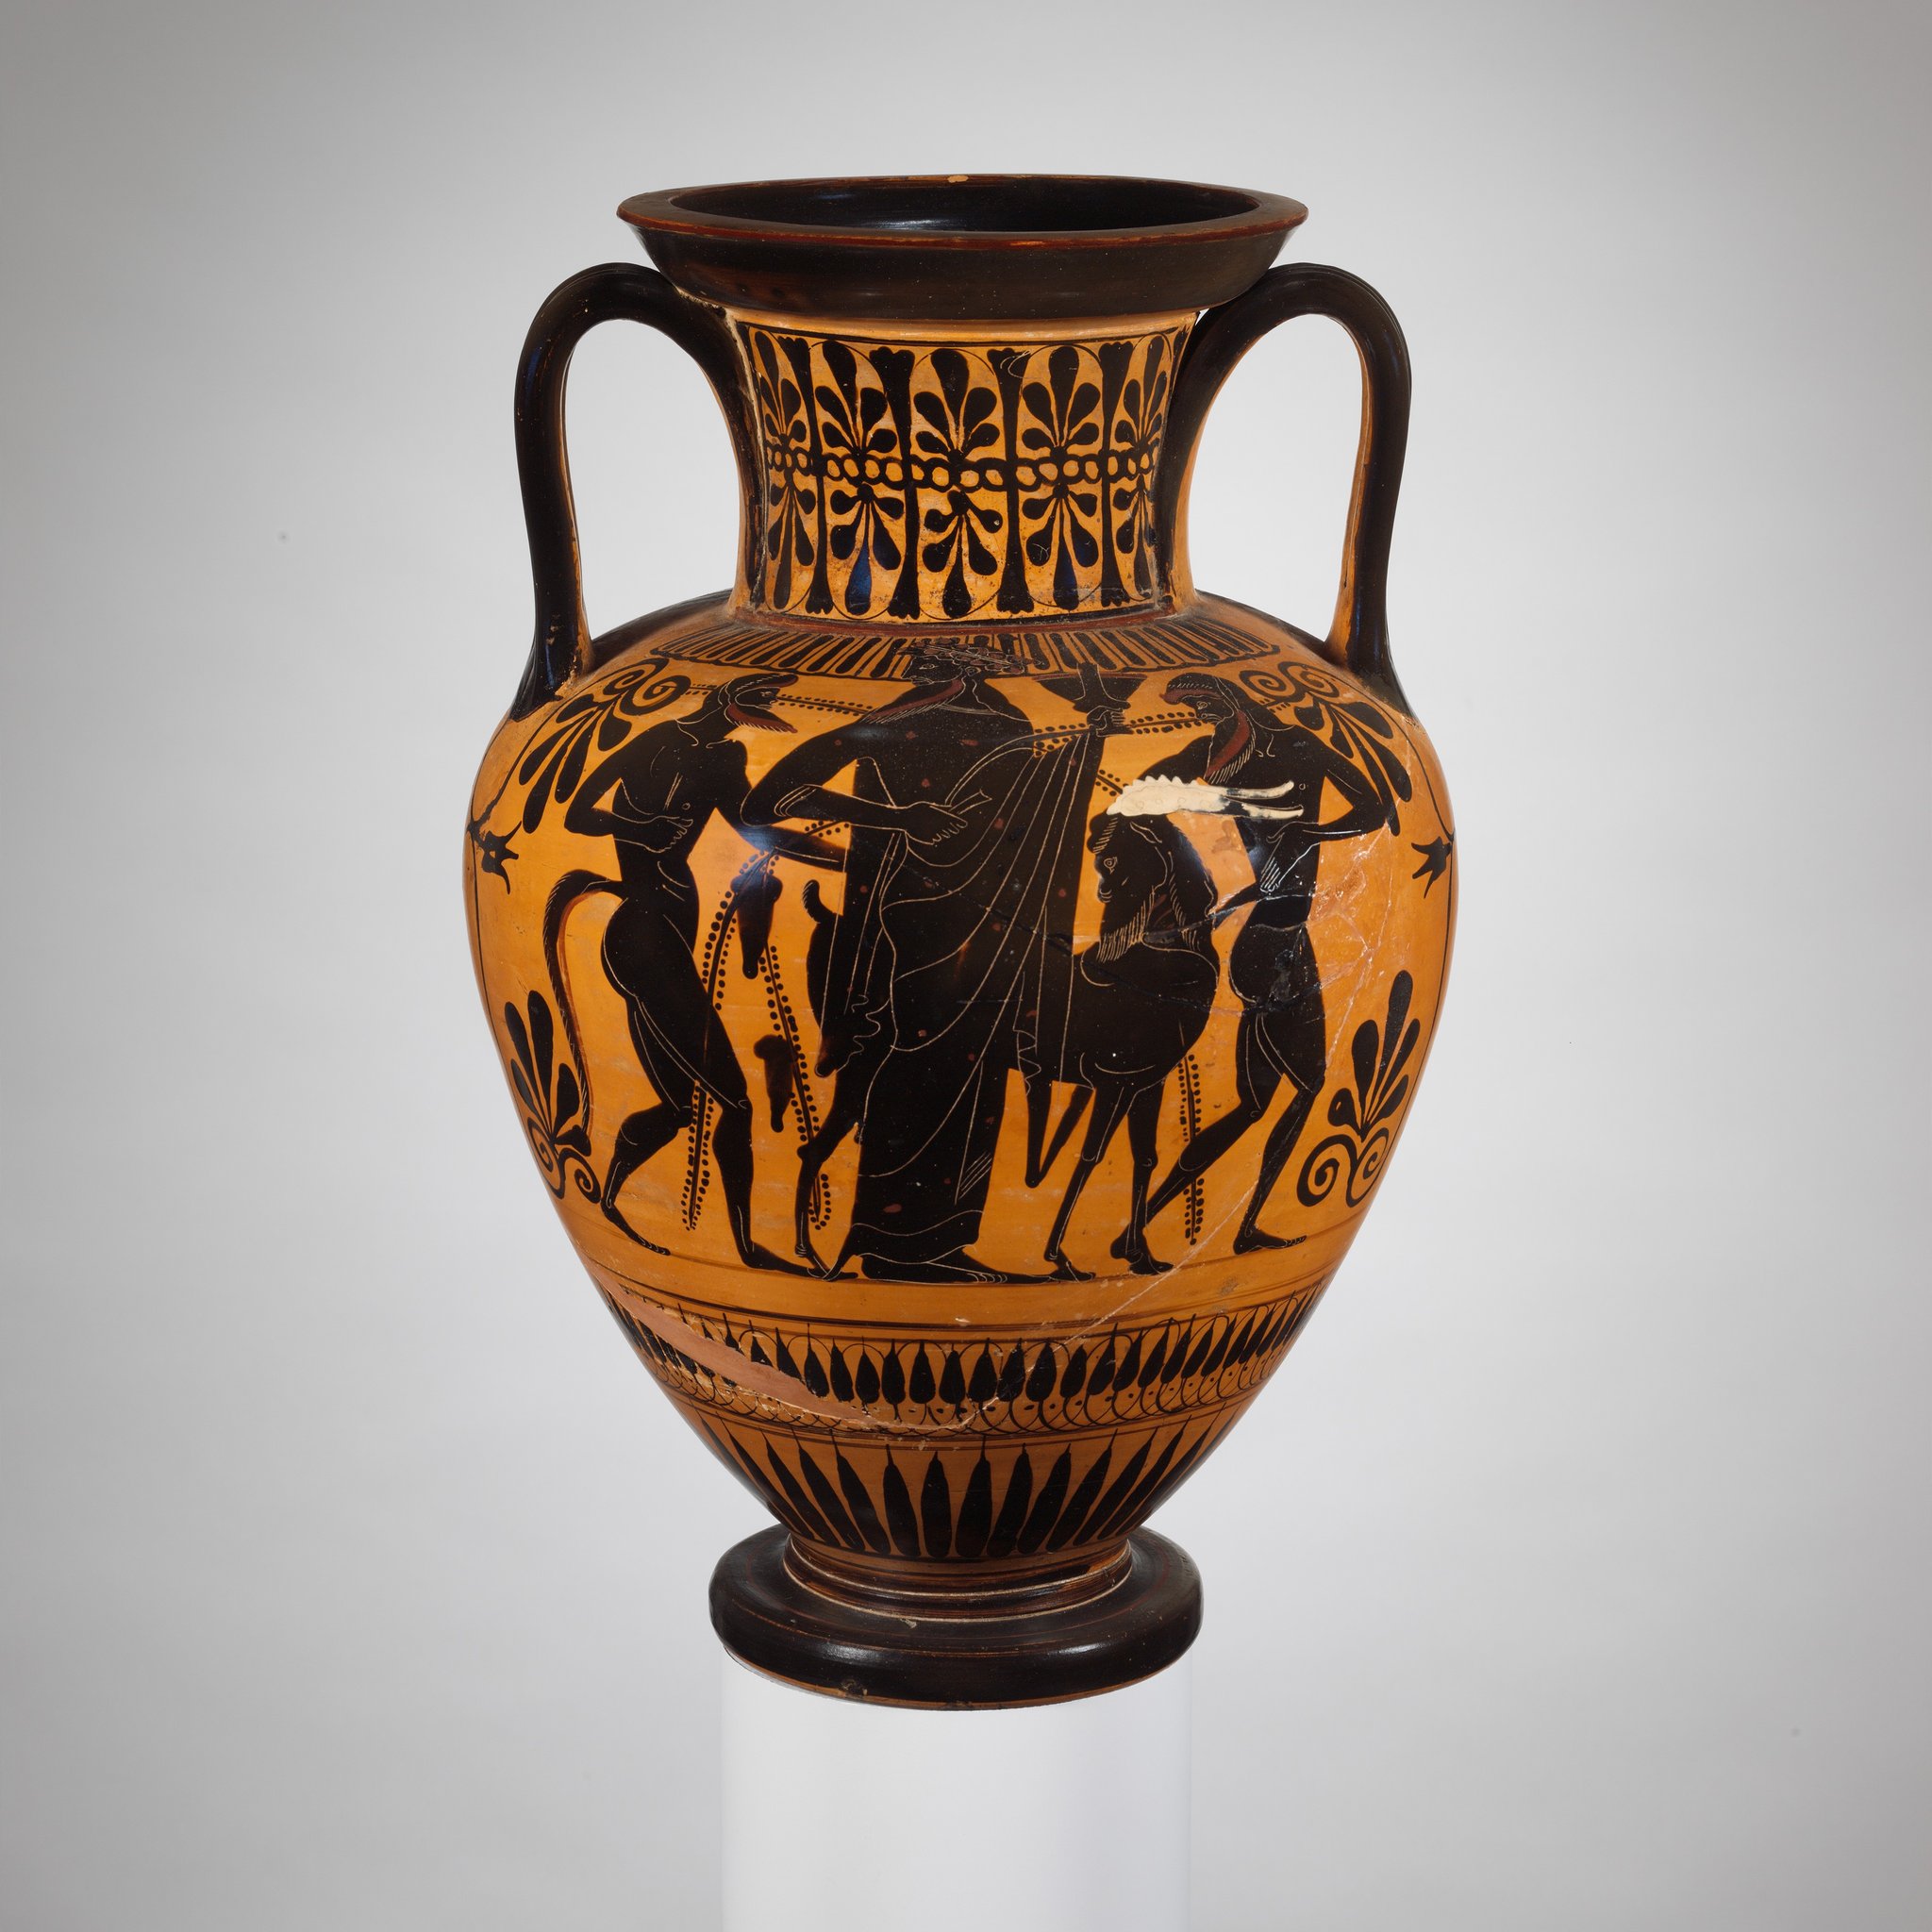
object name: neck amphora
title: Terracotta neck-amphora (jar)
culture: greek, attic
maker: leagros group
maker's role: artist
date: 510-500 BCE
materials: terracotta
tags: men,women,dionysus,satyrs